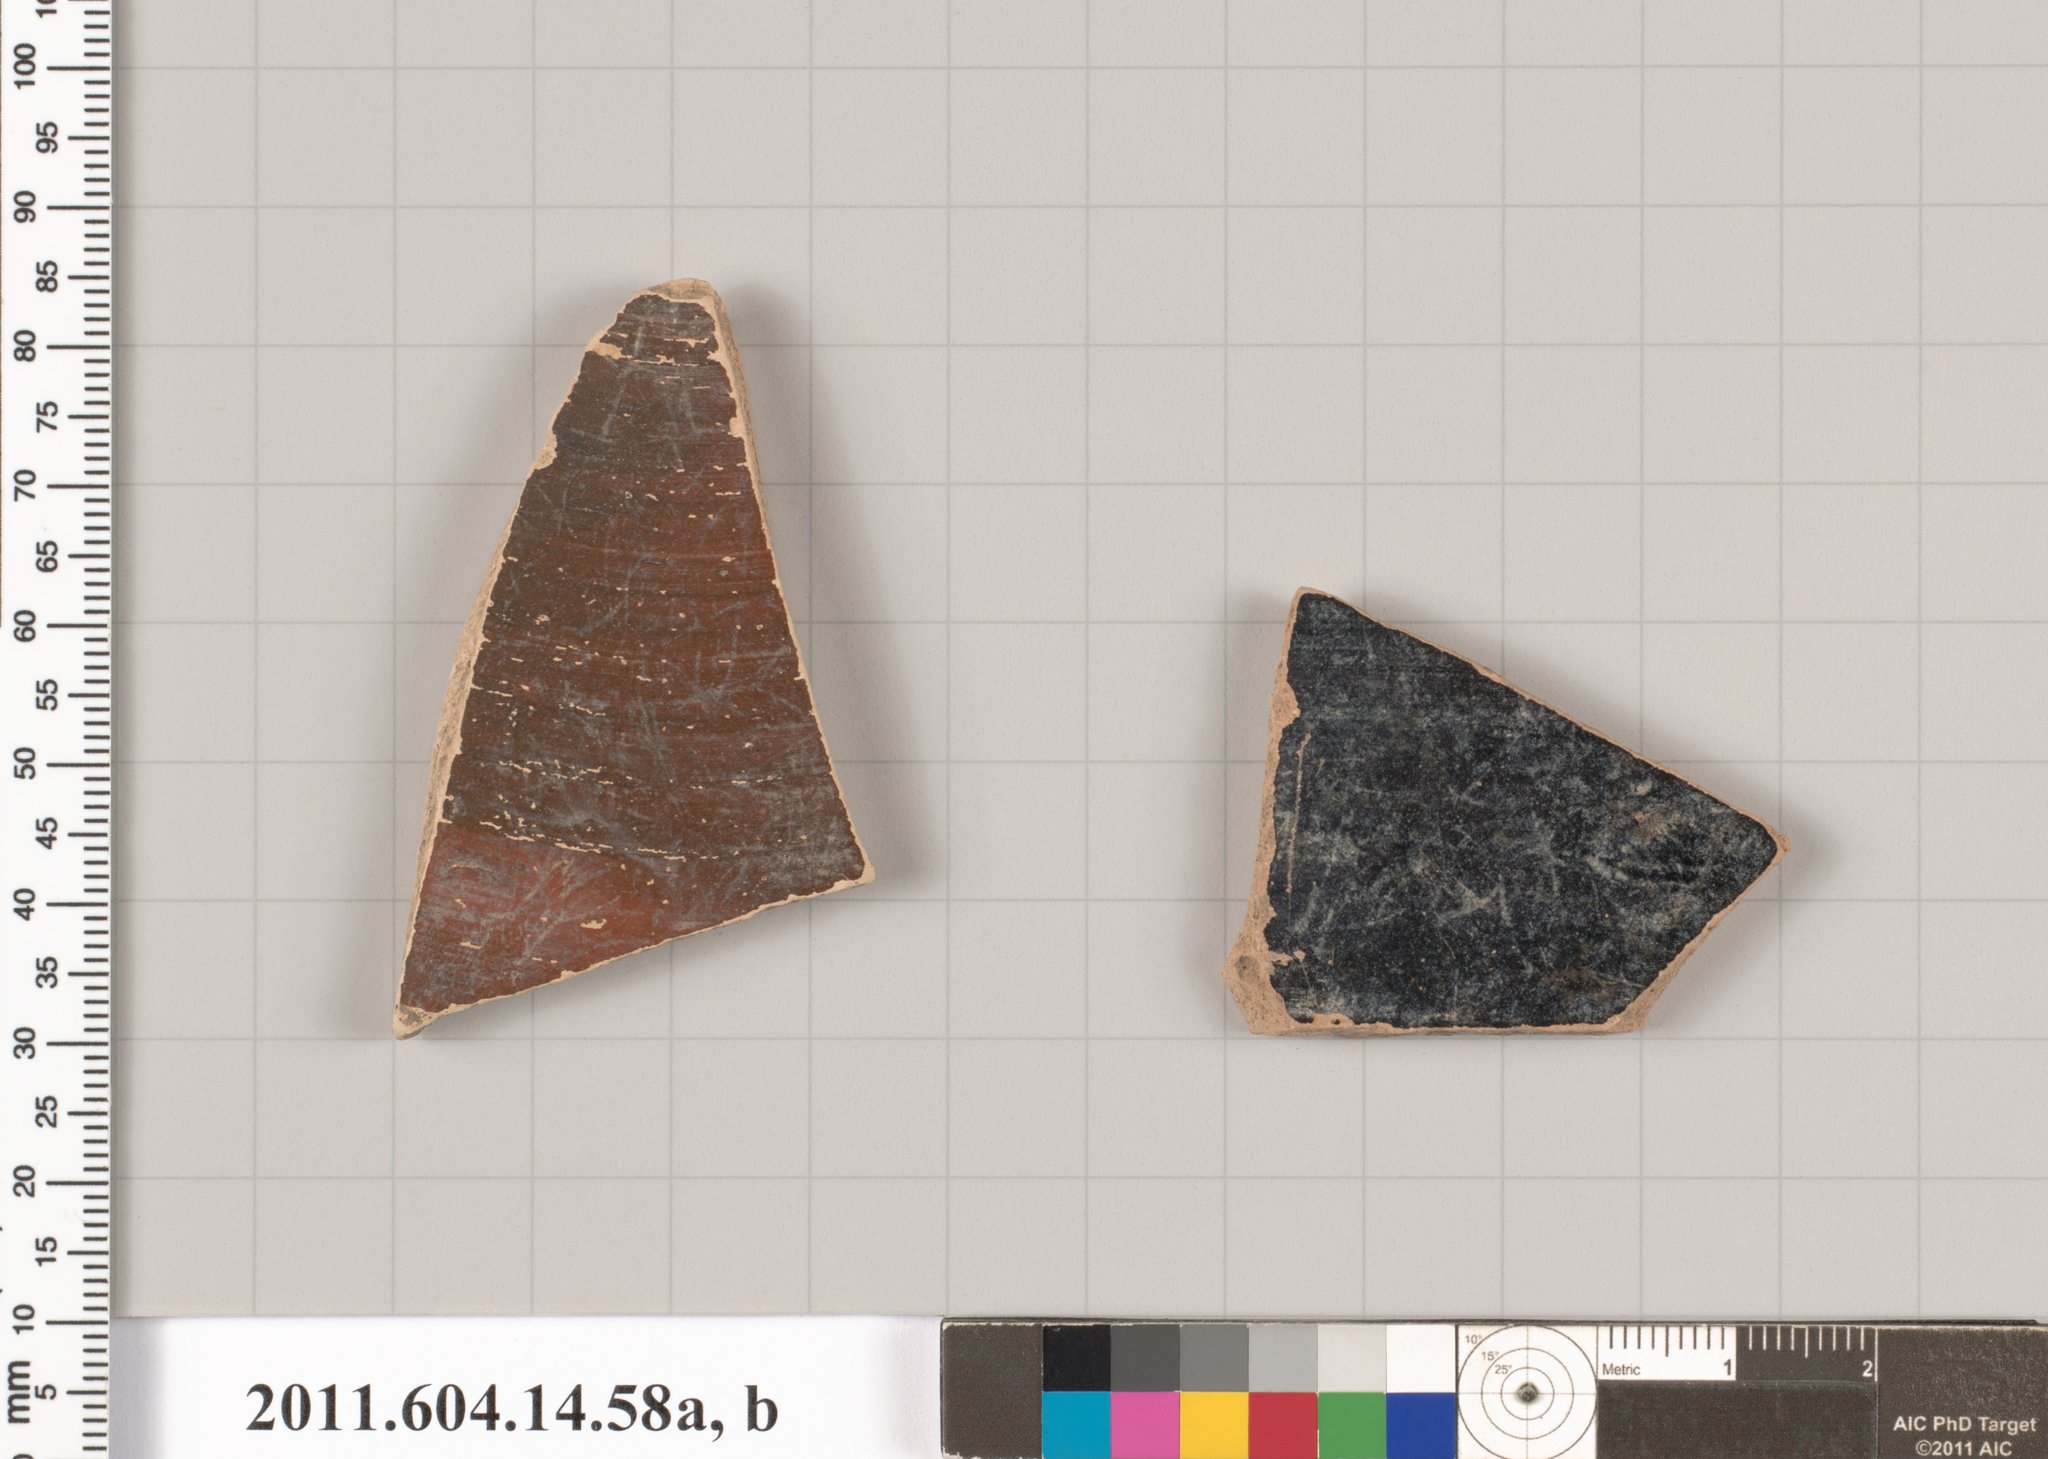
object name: undetermined shape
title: Terracotta fragments of undetermined shapes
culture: unknown fabric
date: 600-301 BCE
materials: terracotta